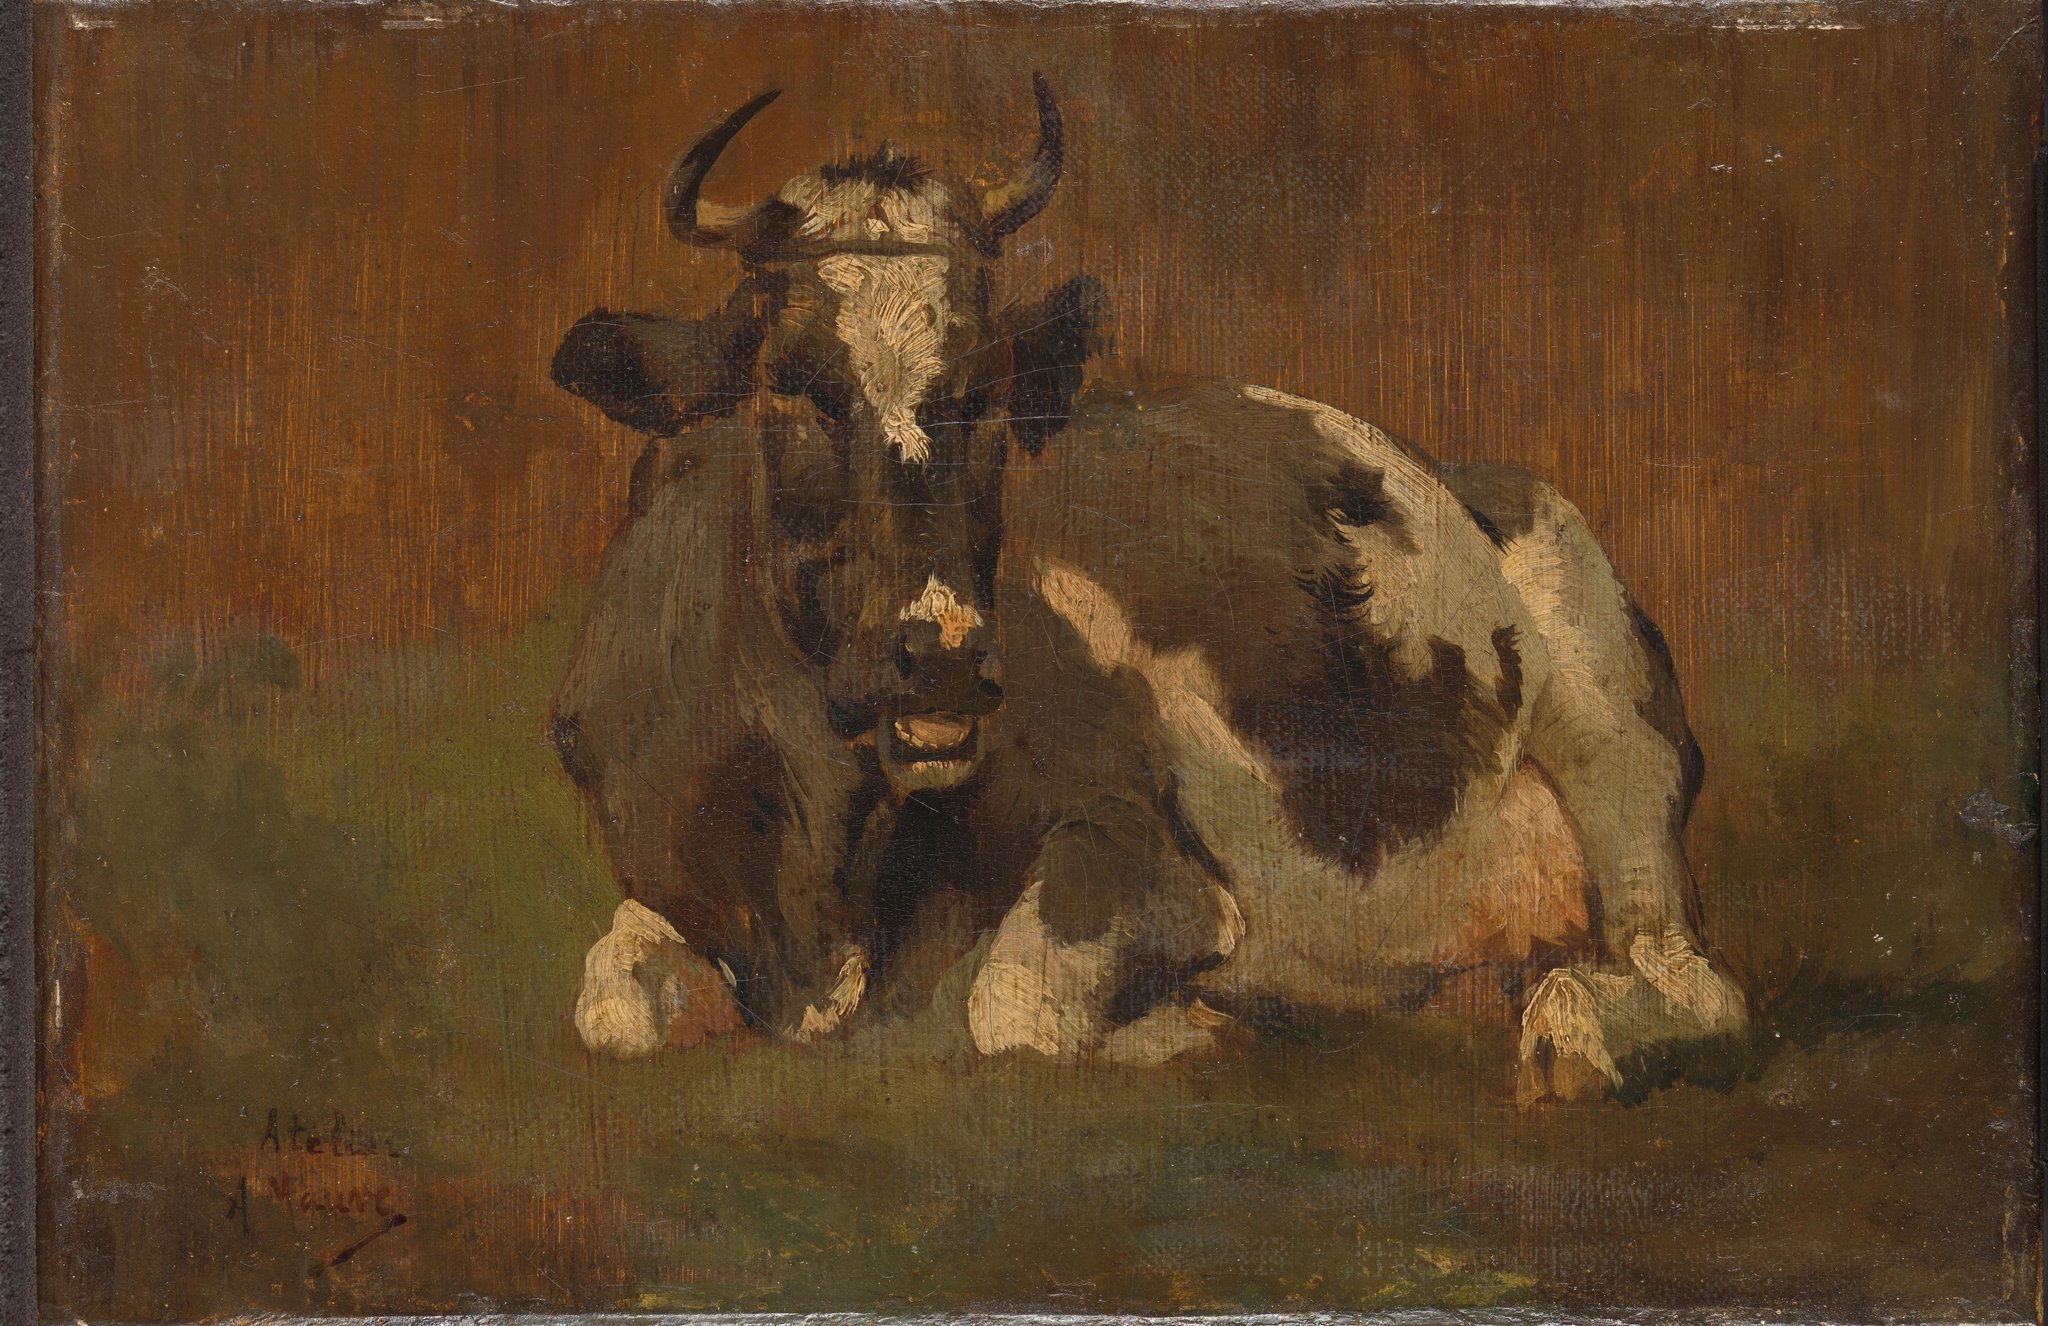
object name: painting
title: Lying Cow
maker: anton mauve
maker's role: draughtsman, painter, print maker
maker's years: 1838-1888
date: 1860-1888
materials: oil, panel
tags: cow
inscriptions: signature: ‘Atelier A Mauve’